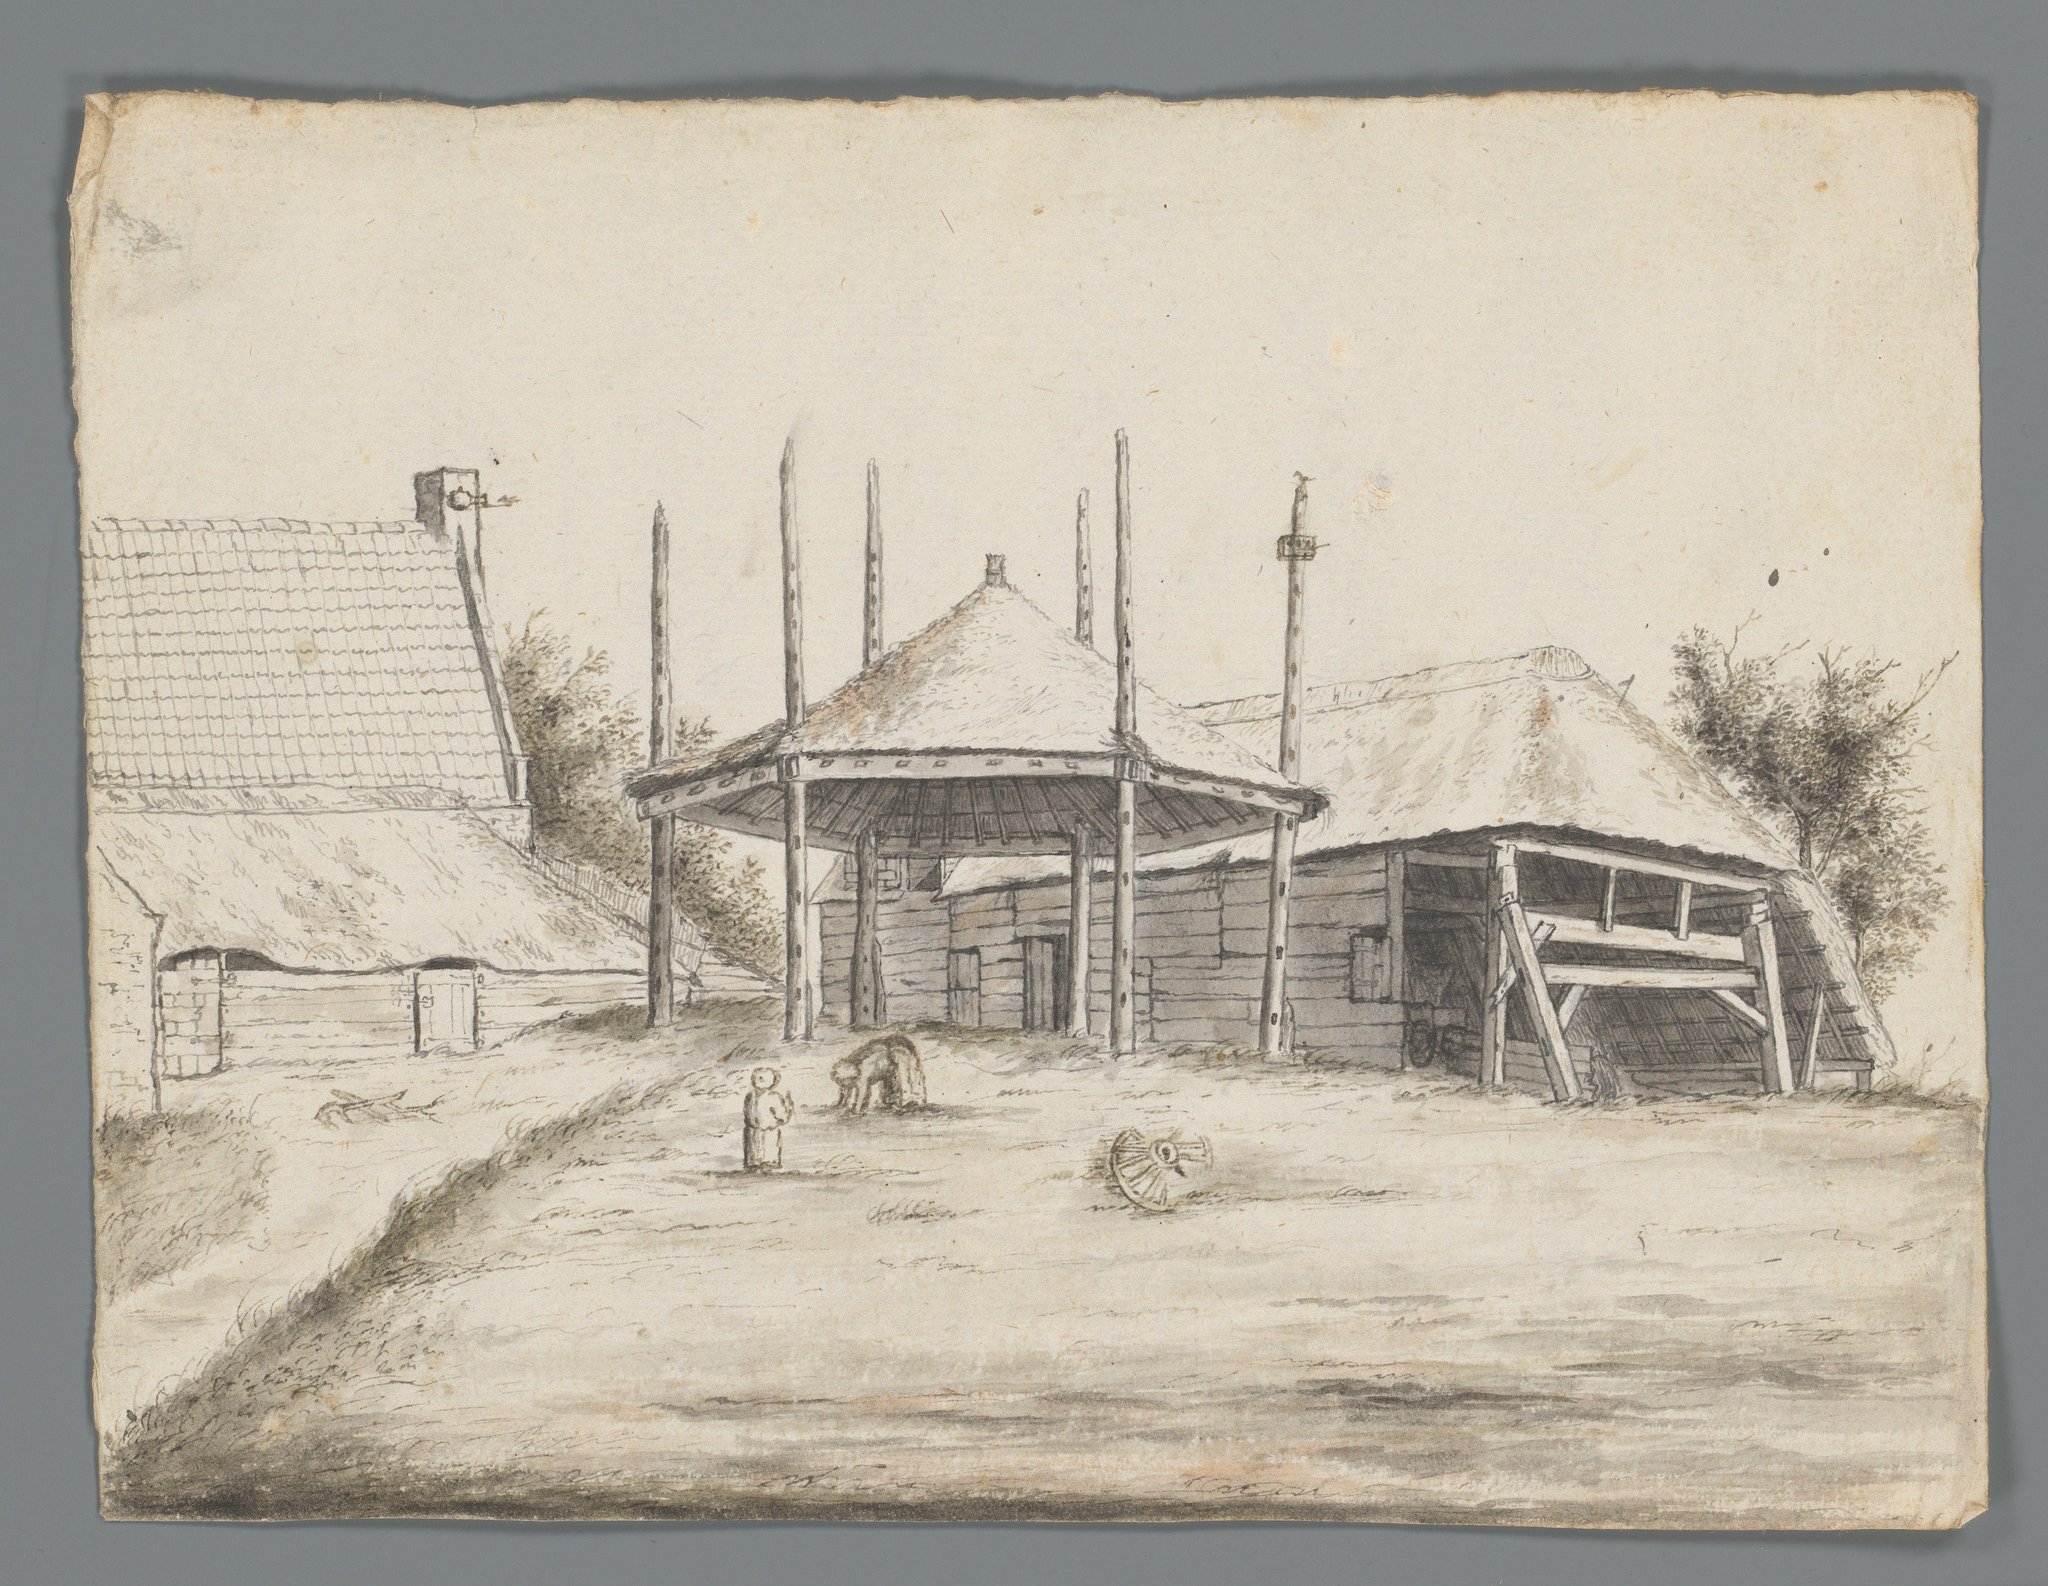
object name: drawing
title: Boerderij met hooischuur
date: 1700-1799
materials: paper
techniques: brush, pen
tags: barn, farm (building)